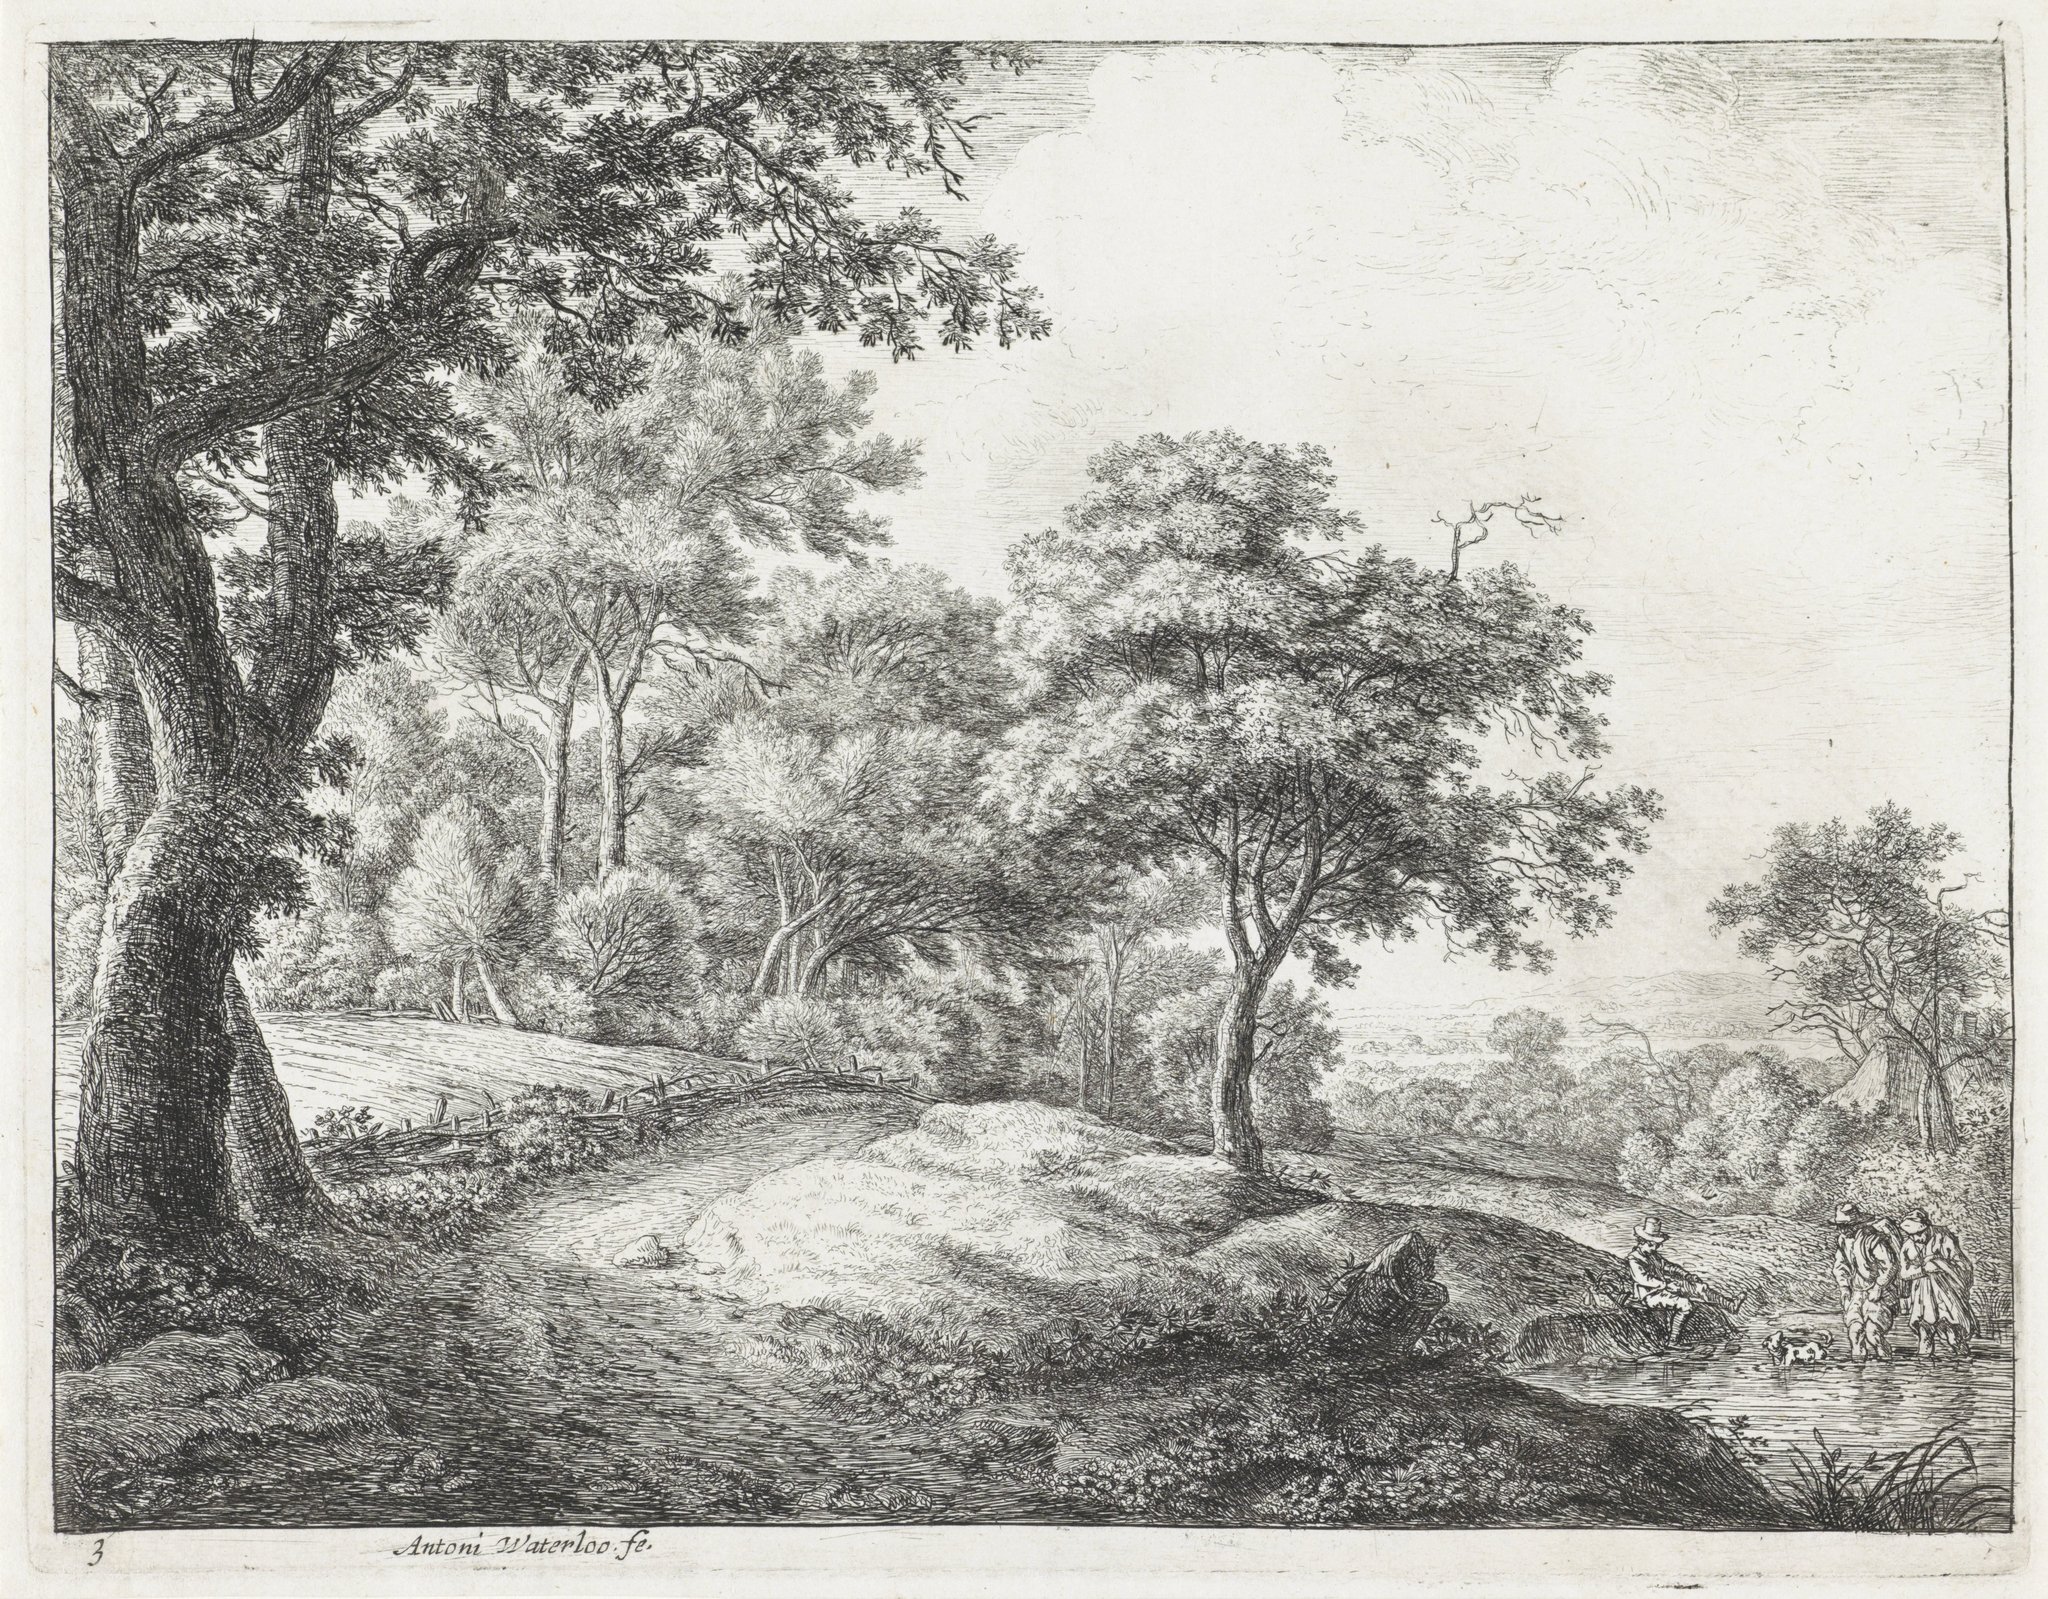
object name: print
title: Grote landschappen, serie A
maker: anthonie waterloo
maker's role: draughtsman, painter, print maker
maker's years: 1609-1690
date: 1630-1663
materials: paper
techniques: etching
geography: amsterdam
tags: brook, forest path or lane, wading, paddling, dog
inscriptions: collector's mark: Lugt 240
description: Links loopt een glooiend bospad. Rechts waden twee figuren met een hond door een beek. Op de oever zit een derde figuur. Achter hen is een huis te zien.